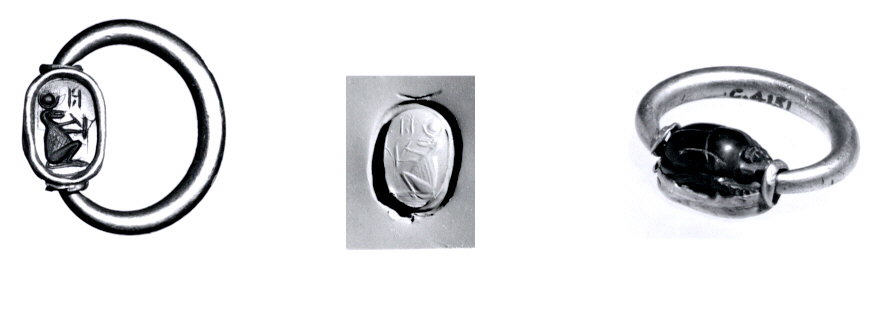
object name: ring with scaraboid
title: Gold ring with carnelian scaraboid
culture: cypriot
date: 600-401 BCE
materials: gemstone, gold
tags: writing